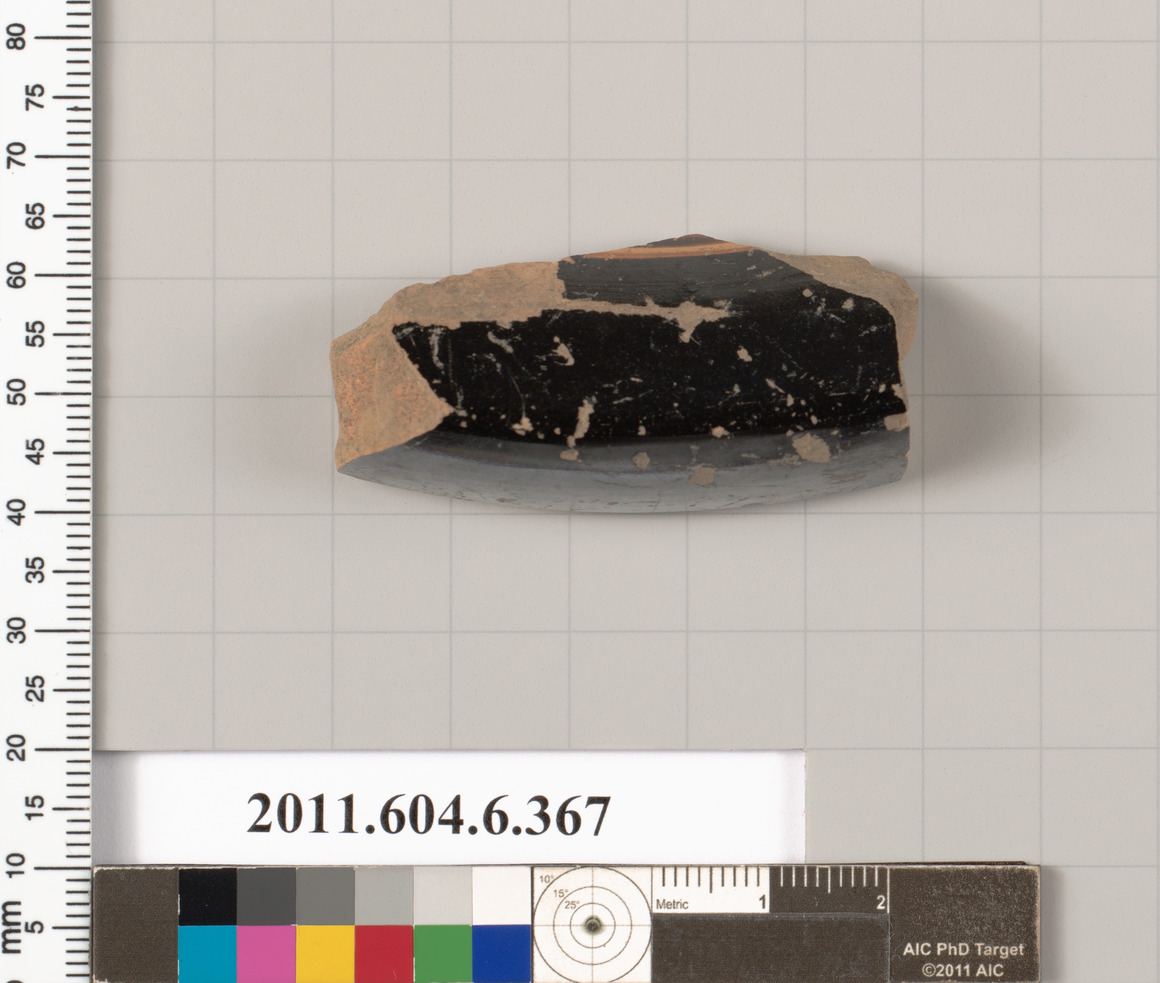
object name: plate fragment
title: Terracotta fragment of a plate?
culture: greek, attic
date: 500-401 BCE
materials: terracotta